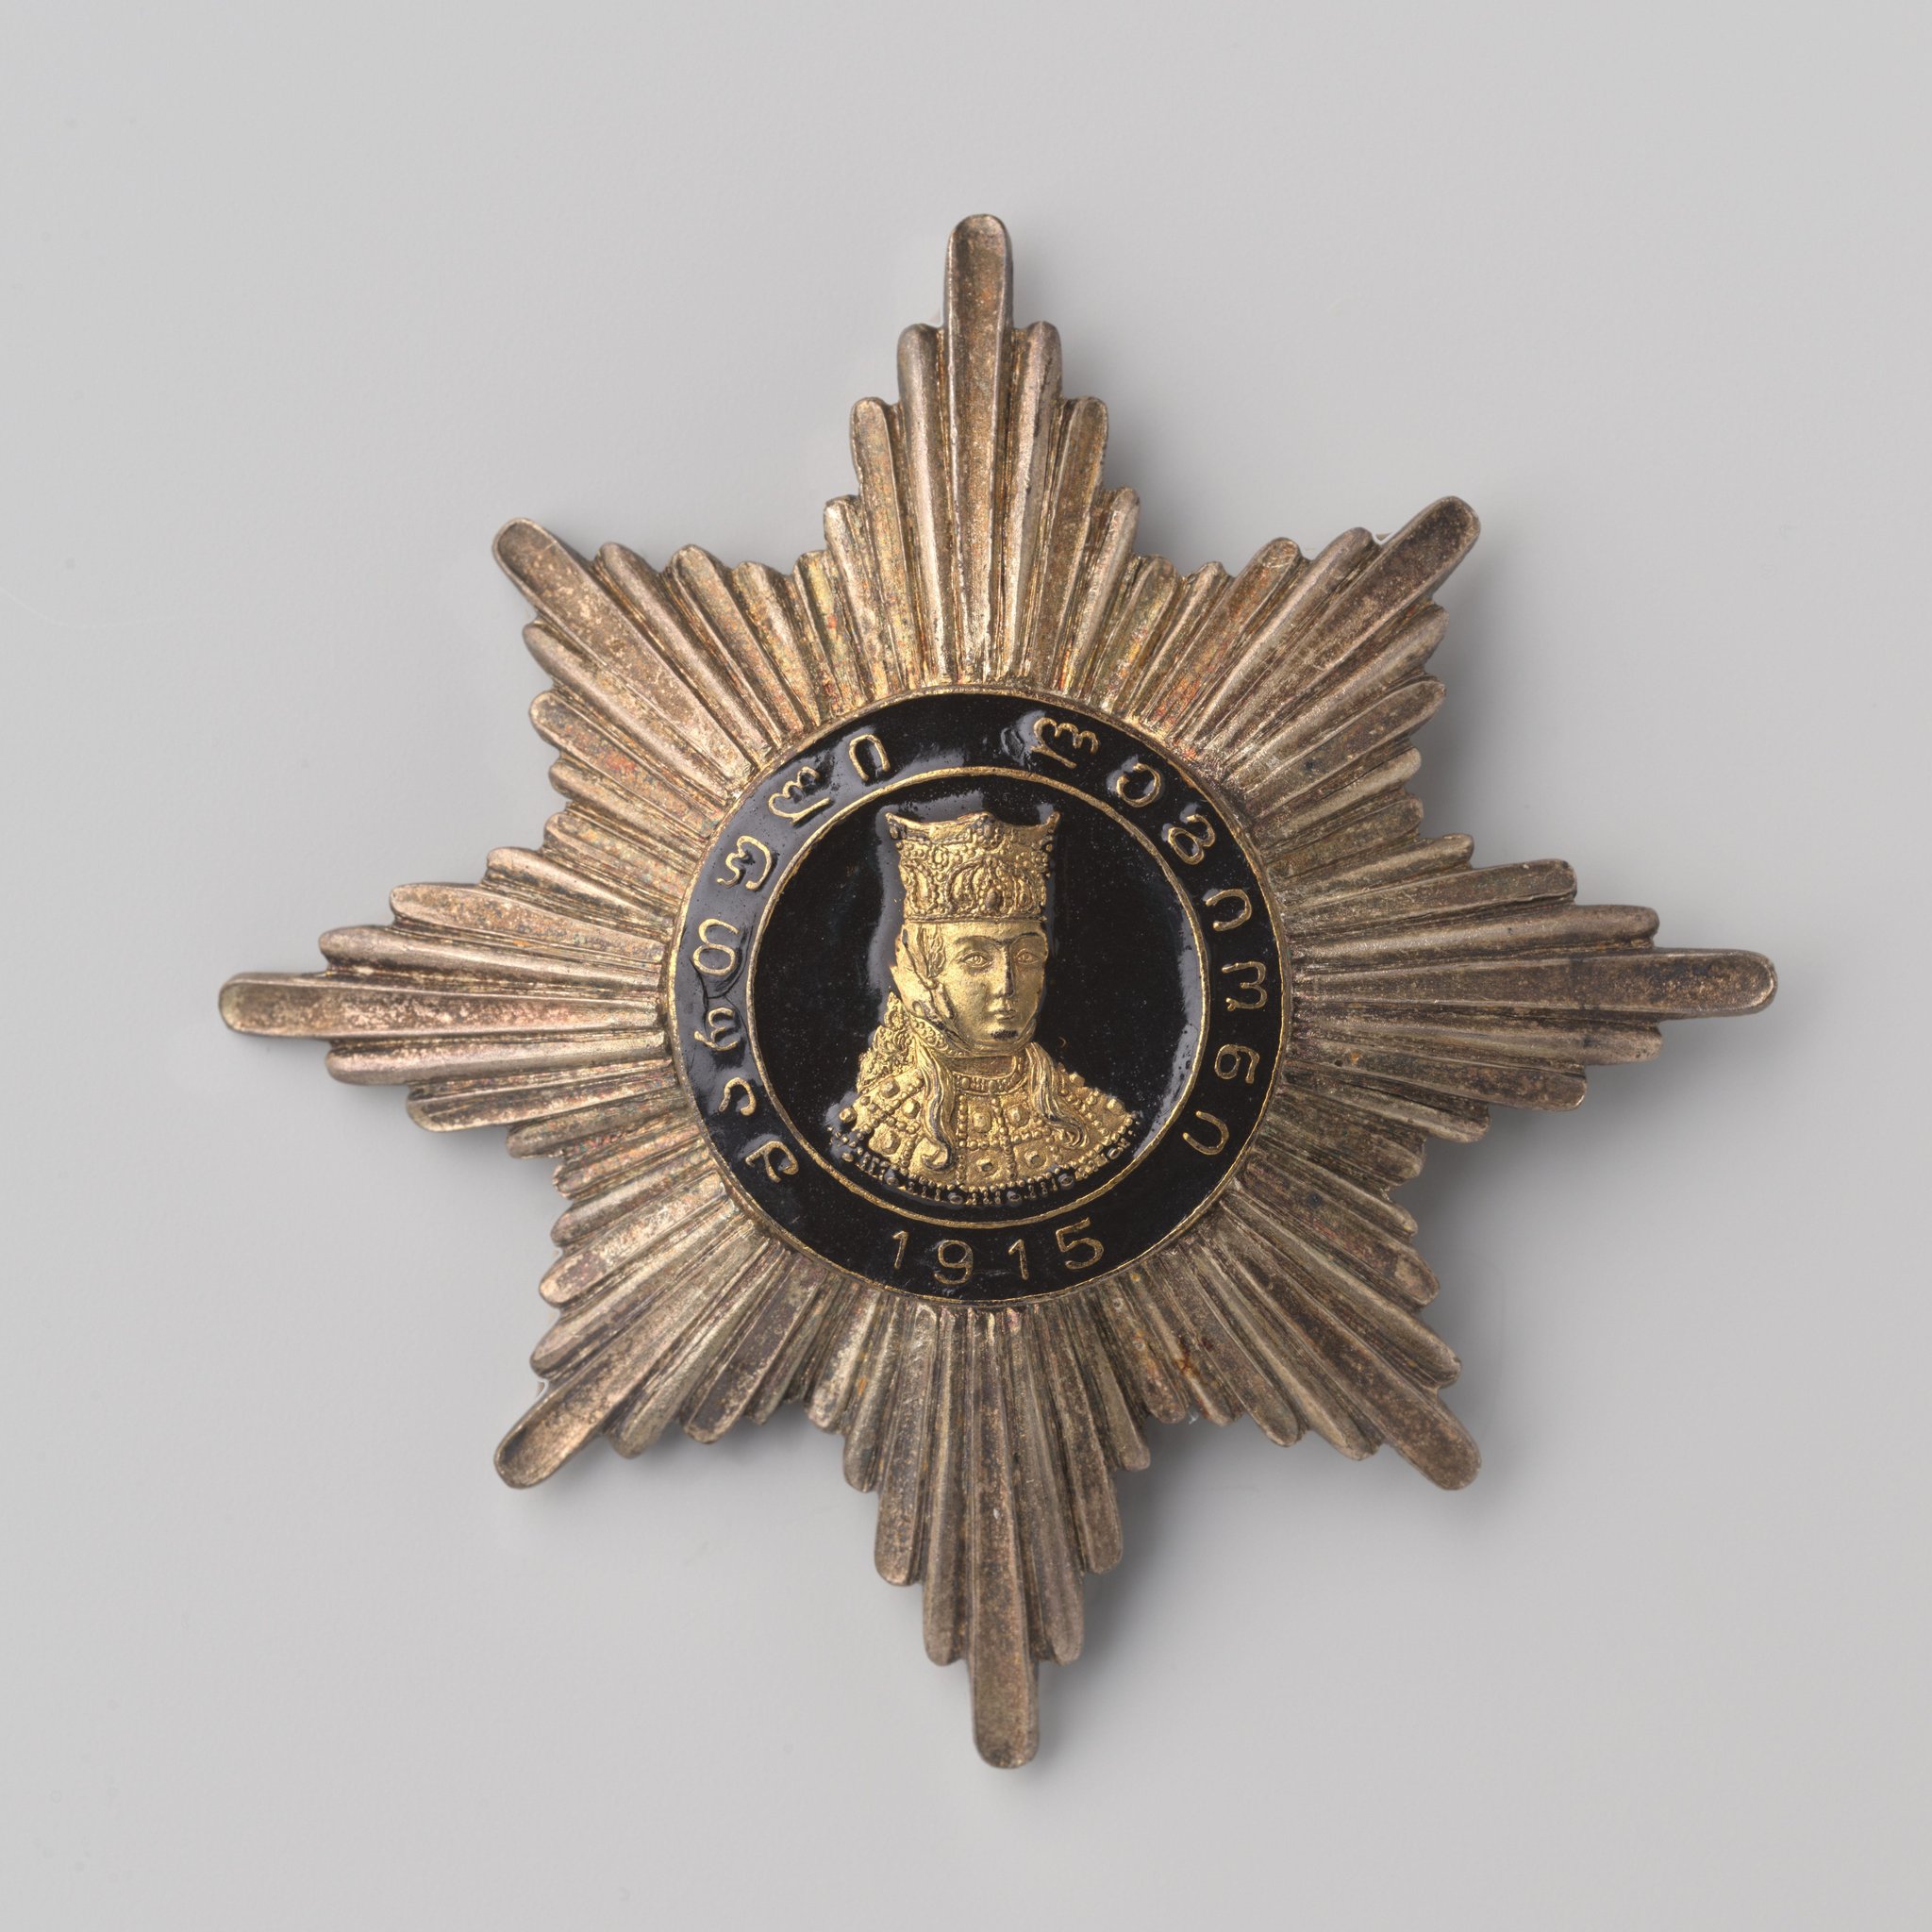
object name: borstster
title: Borstster, 1915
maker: Anonymous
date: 1900-1925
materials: silver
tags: eugen wachenheimer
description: Dit object is onderdeel van de nalatenschap van Isabel Elon-Wachenheimer (1928-2010). Tot haar overlijden behoorde het samen met de andere objecten uit de nalatenschap tot haar privédomein van Isabel Wachenheimer. In die particuliere context zijn deze objecten tezamen en individueel aandenkens - aan de jeugd, ouders en familie van Isabel Wachenheimer vóór en tijdens de Shoah en aan haar leven na de Tweede Wereldoorlog. Isabel Wachenheimer, die van juni 1943 tot mei 1945 gevangen zat in Kamp Westerbork, Theresienstadt, Auschwitz, Lenzing a/d Oberdonau (een buitenkamp van Mauthausen), overleefde de Shoah. Haar ouders – Eugène Wachenheimer en Else Wachenheimer-Moos - werden op 14 oktober 1944 in Auschwitz-Birkenau vermoord.